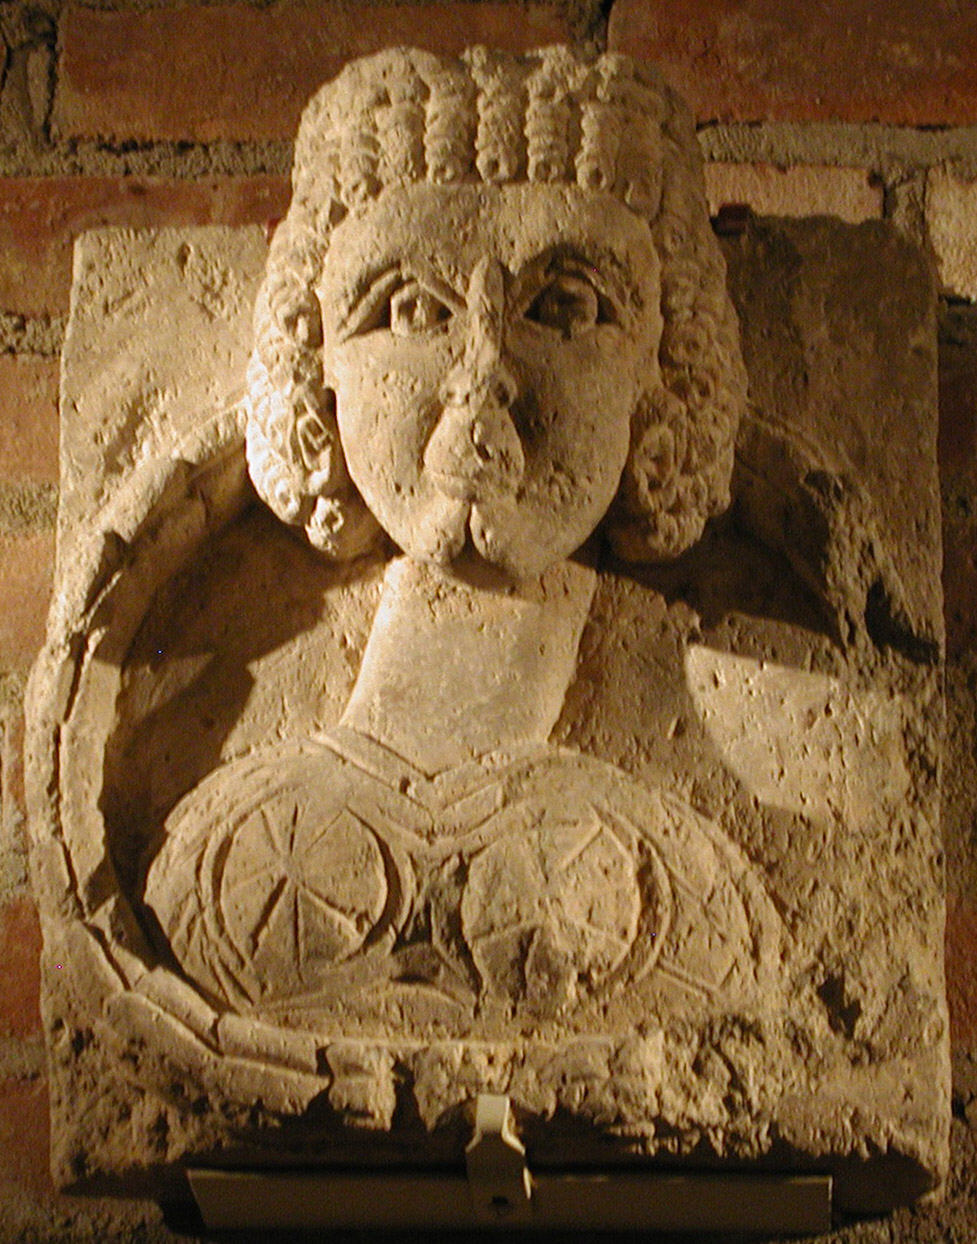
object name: relief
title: Fragment from a Relief with the Bust of a Woman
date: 301-500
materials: limestone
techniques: carving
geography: egypt or syria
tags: women